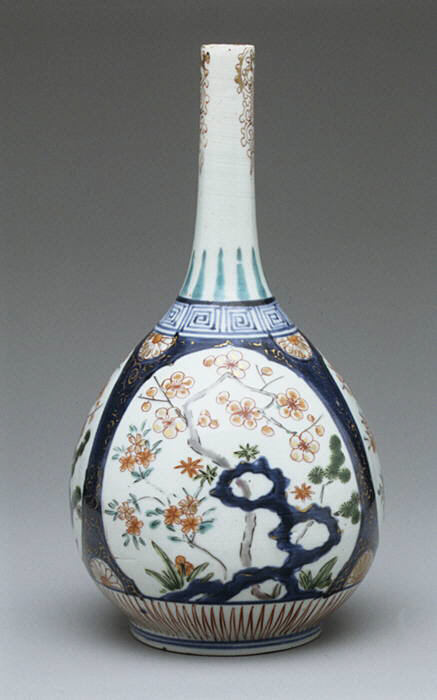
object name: vase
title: Vase (one of a pair)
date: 1700-1720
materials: hard paste porcelain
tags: flowers,plants